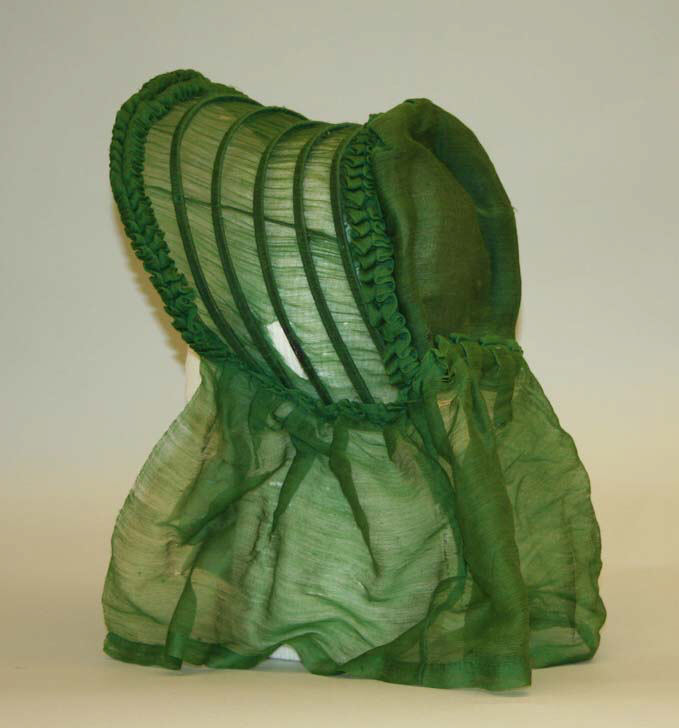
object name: bonnet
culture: american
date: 1801-1833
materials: wool